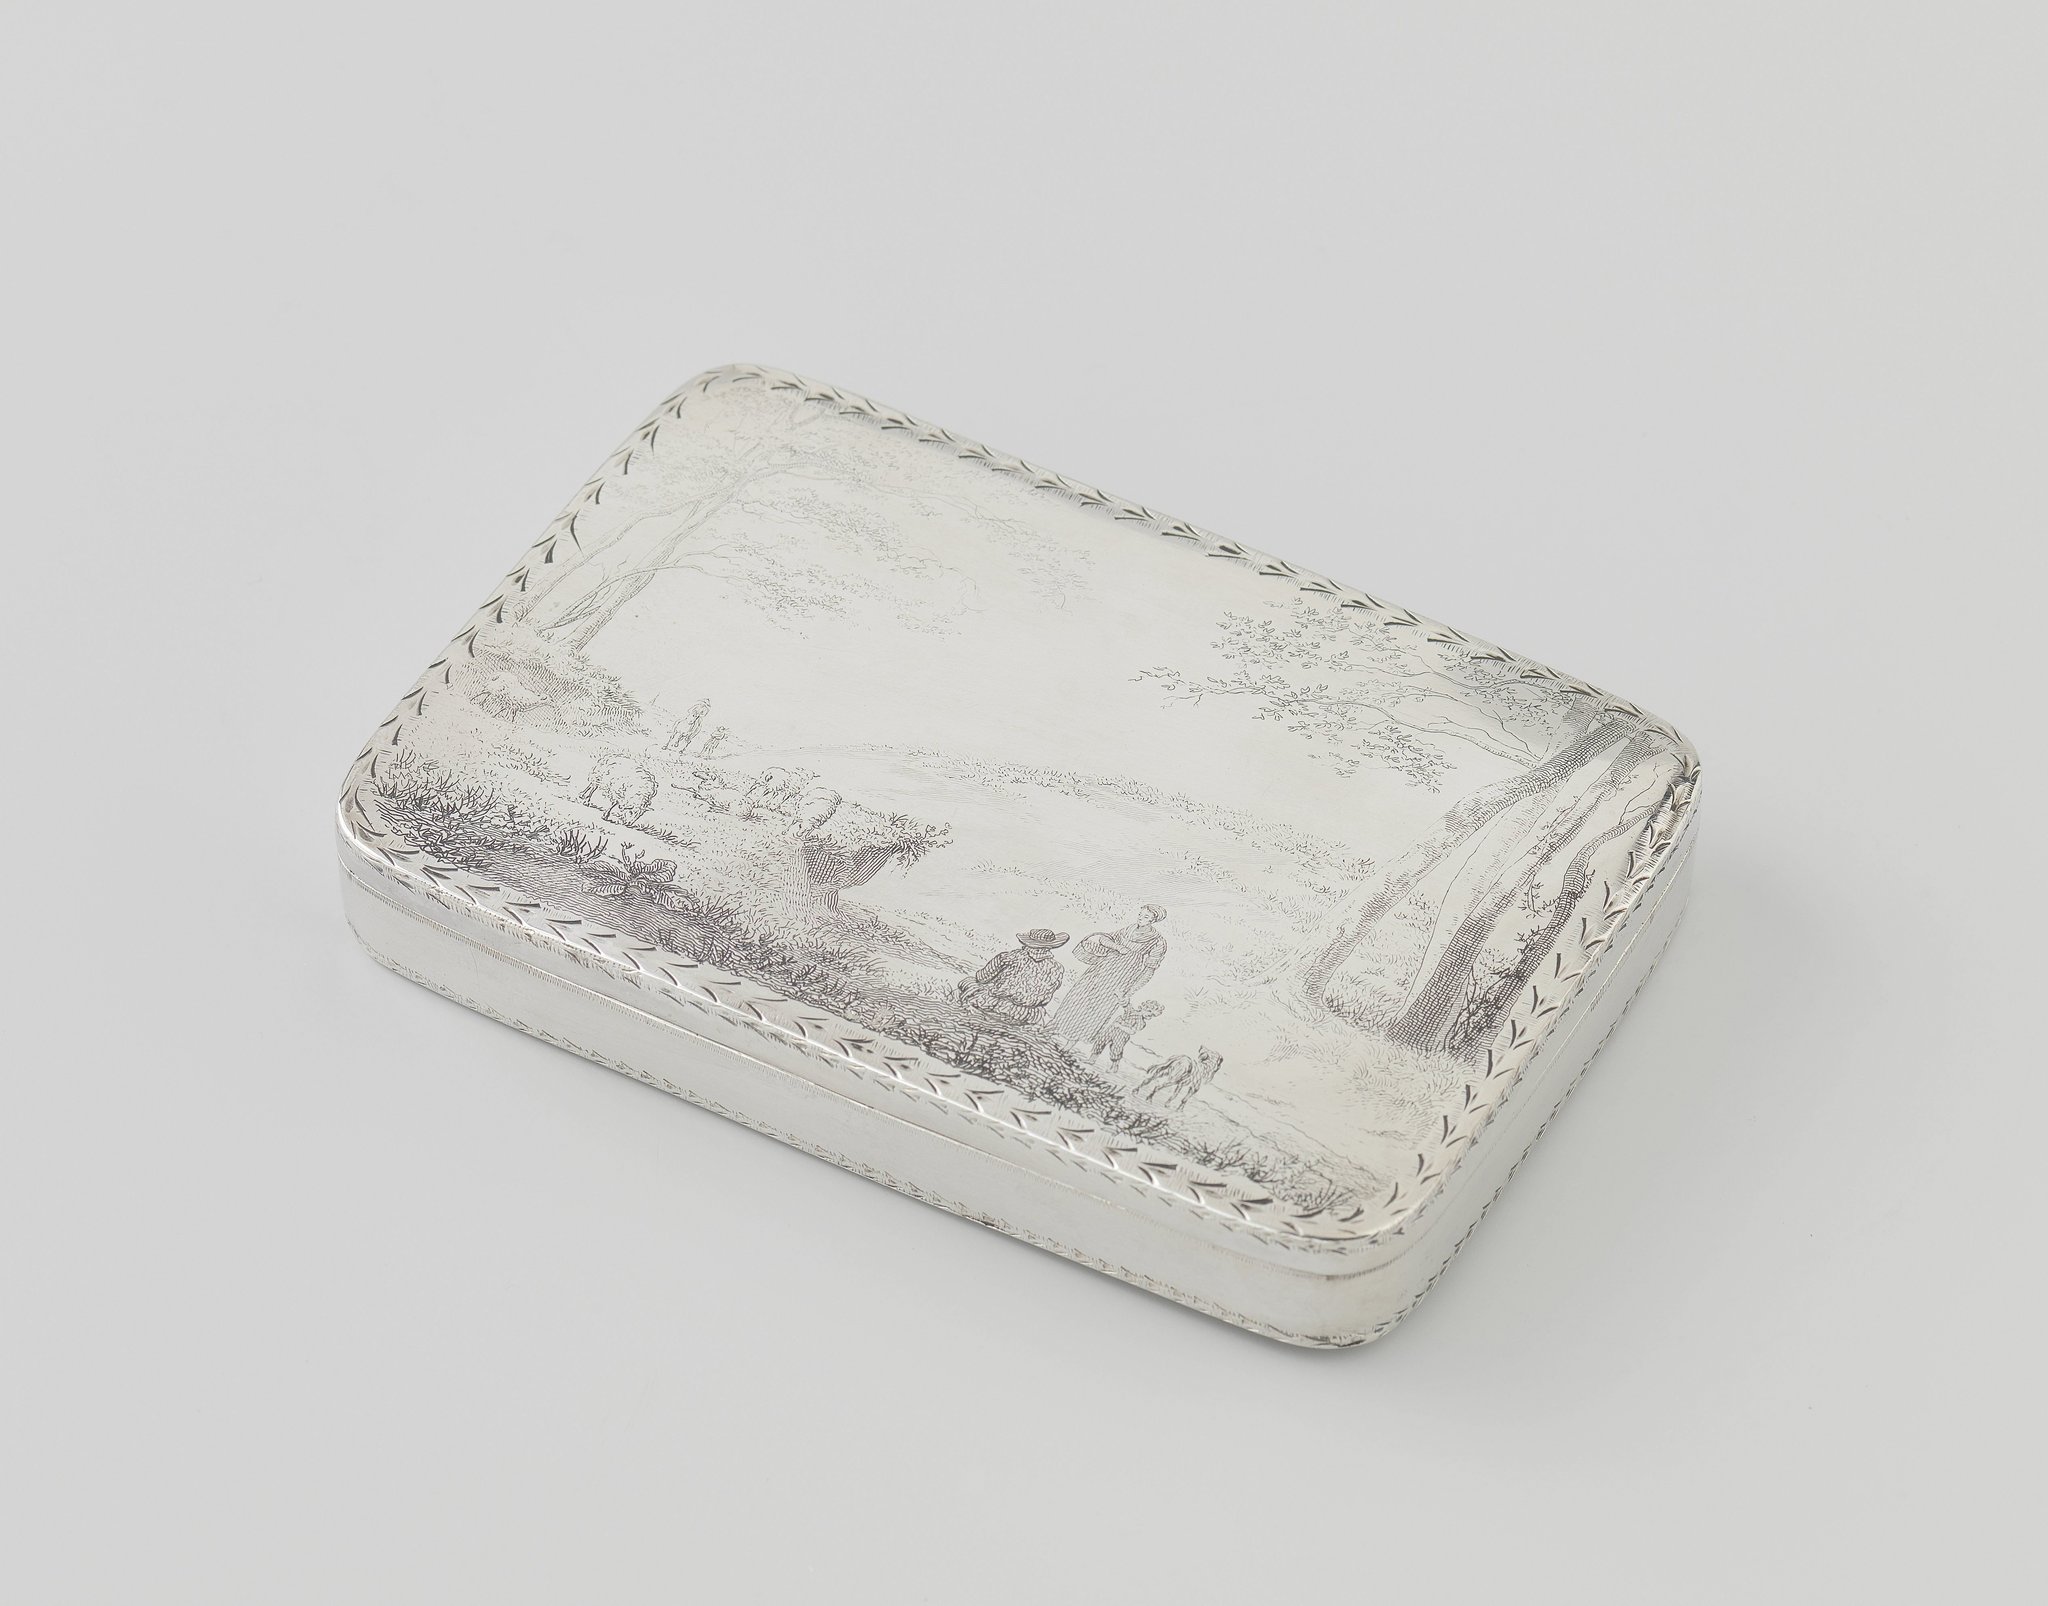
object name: tobacco box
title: Tabaksdoos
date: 1800-1810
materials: silver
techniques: engraving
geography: haarlem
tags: parents with their children, landscapes in the temperate zone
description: Platte tabaksdoos van zilver, langwerpig met afgeronde hoeken. Op het deksel is een heuvellandschap gegraveerd, met op de voorgrond een man, vrouw en jongetje met hond.